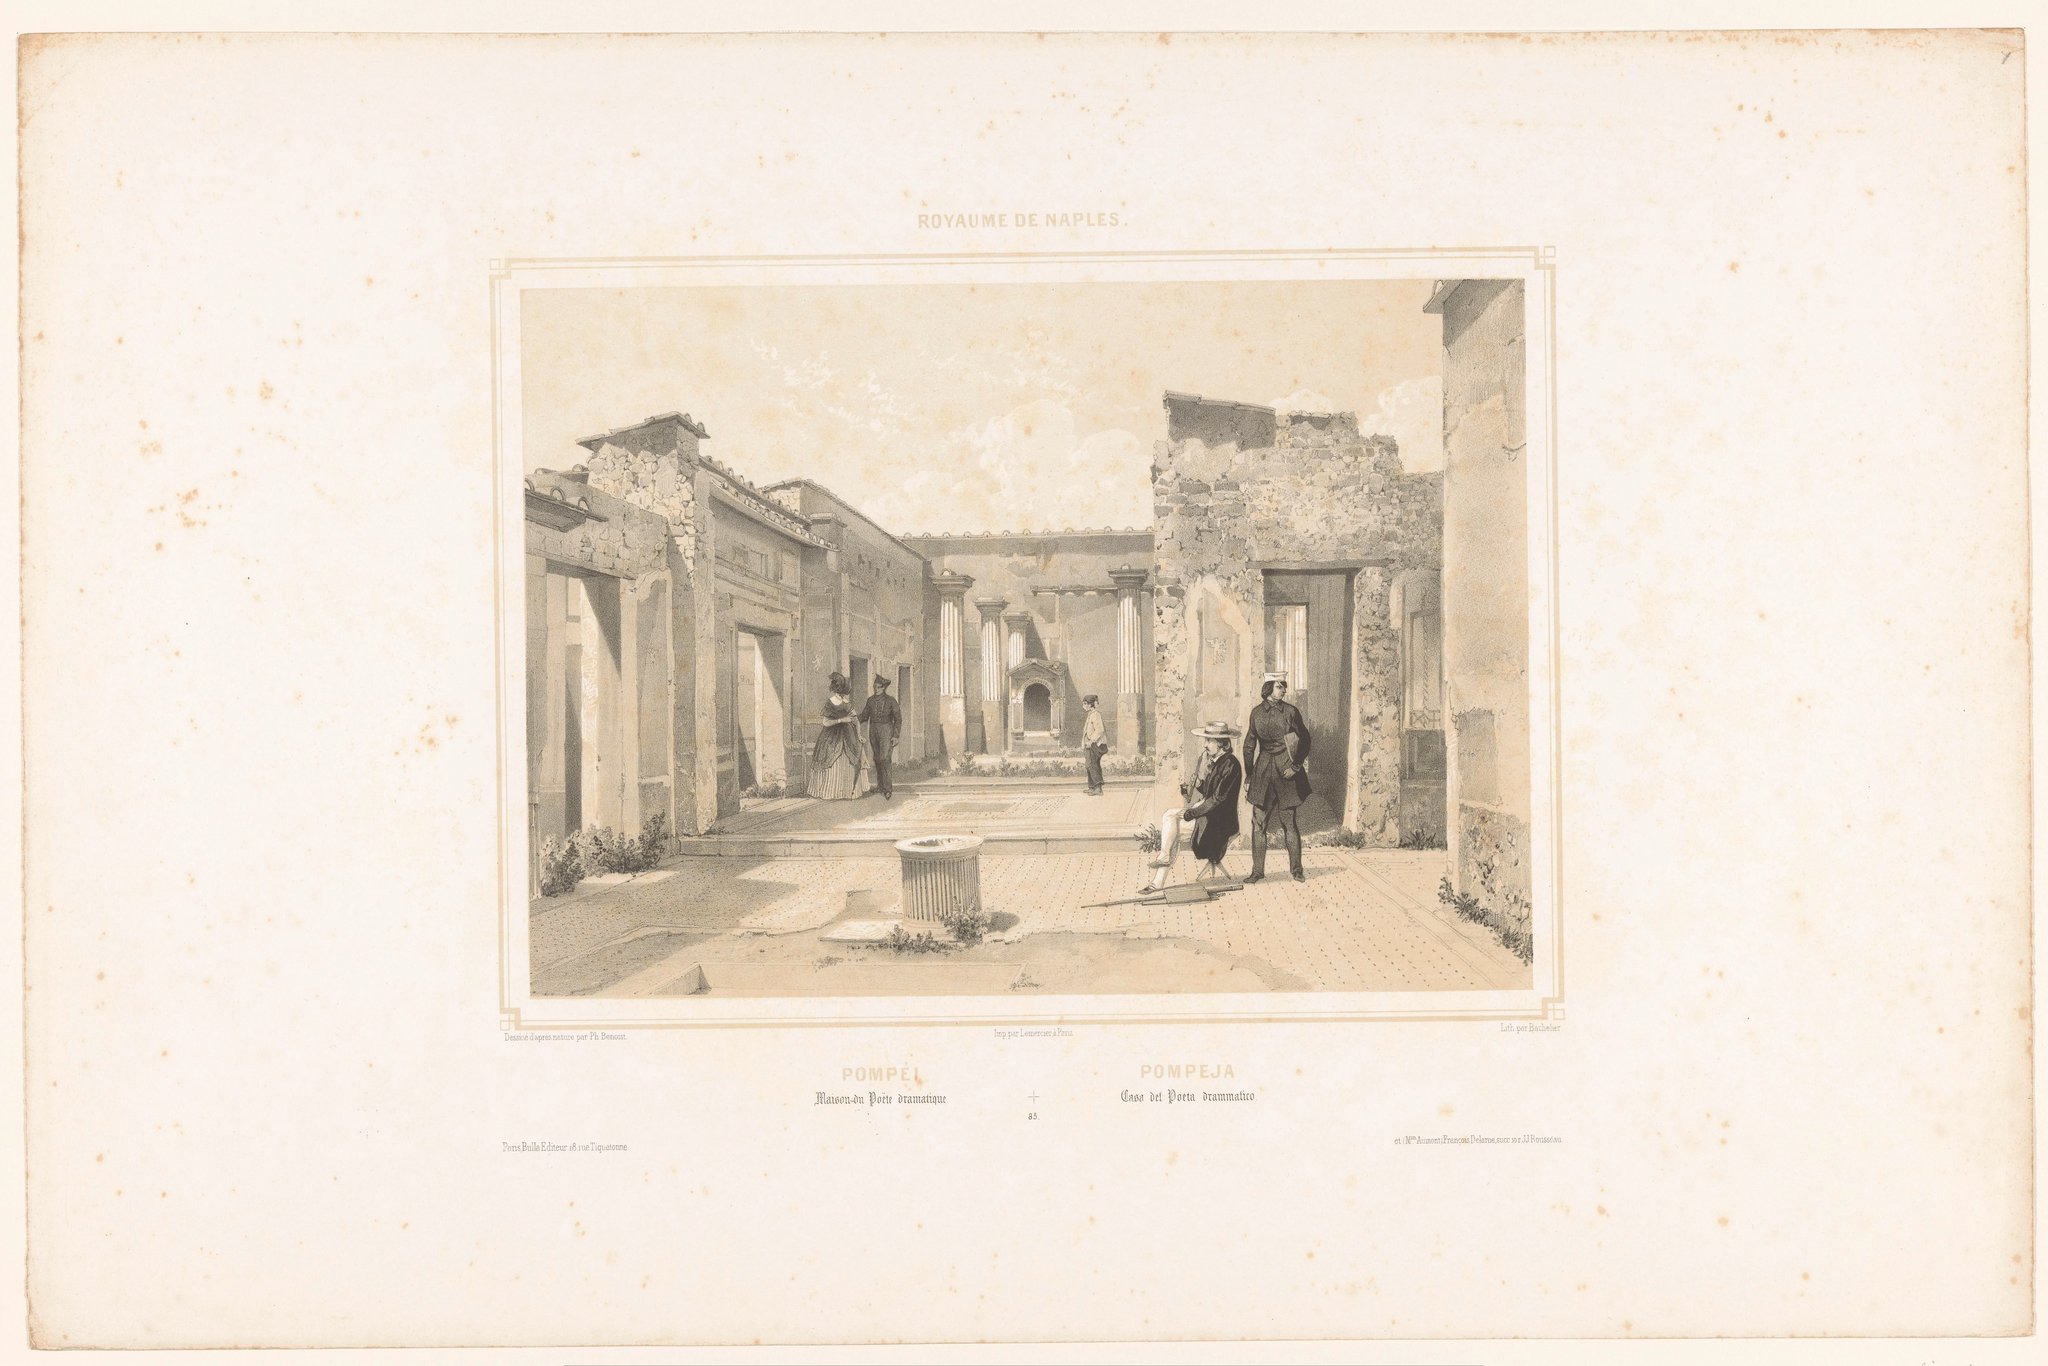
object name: print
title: Royaume de Naples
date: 1847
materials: paper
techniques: tone lithography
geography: paris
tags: ruin of a dwelling, house, castle, etc., pompeii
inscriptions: collector's mark: Lugt 2228a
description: Vermoedelijk maakt de serie deel uit van 'L'Italie monumentale et artistique' (IFF dl. 1, p. 251).